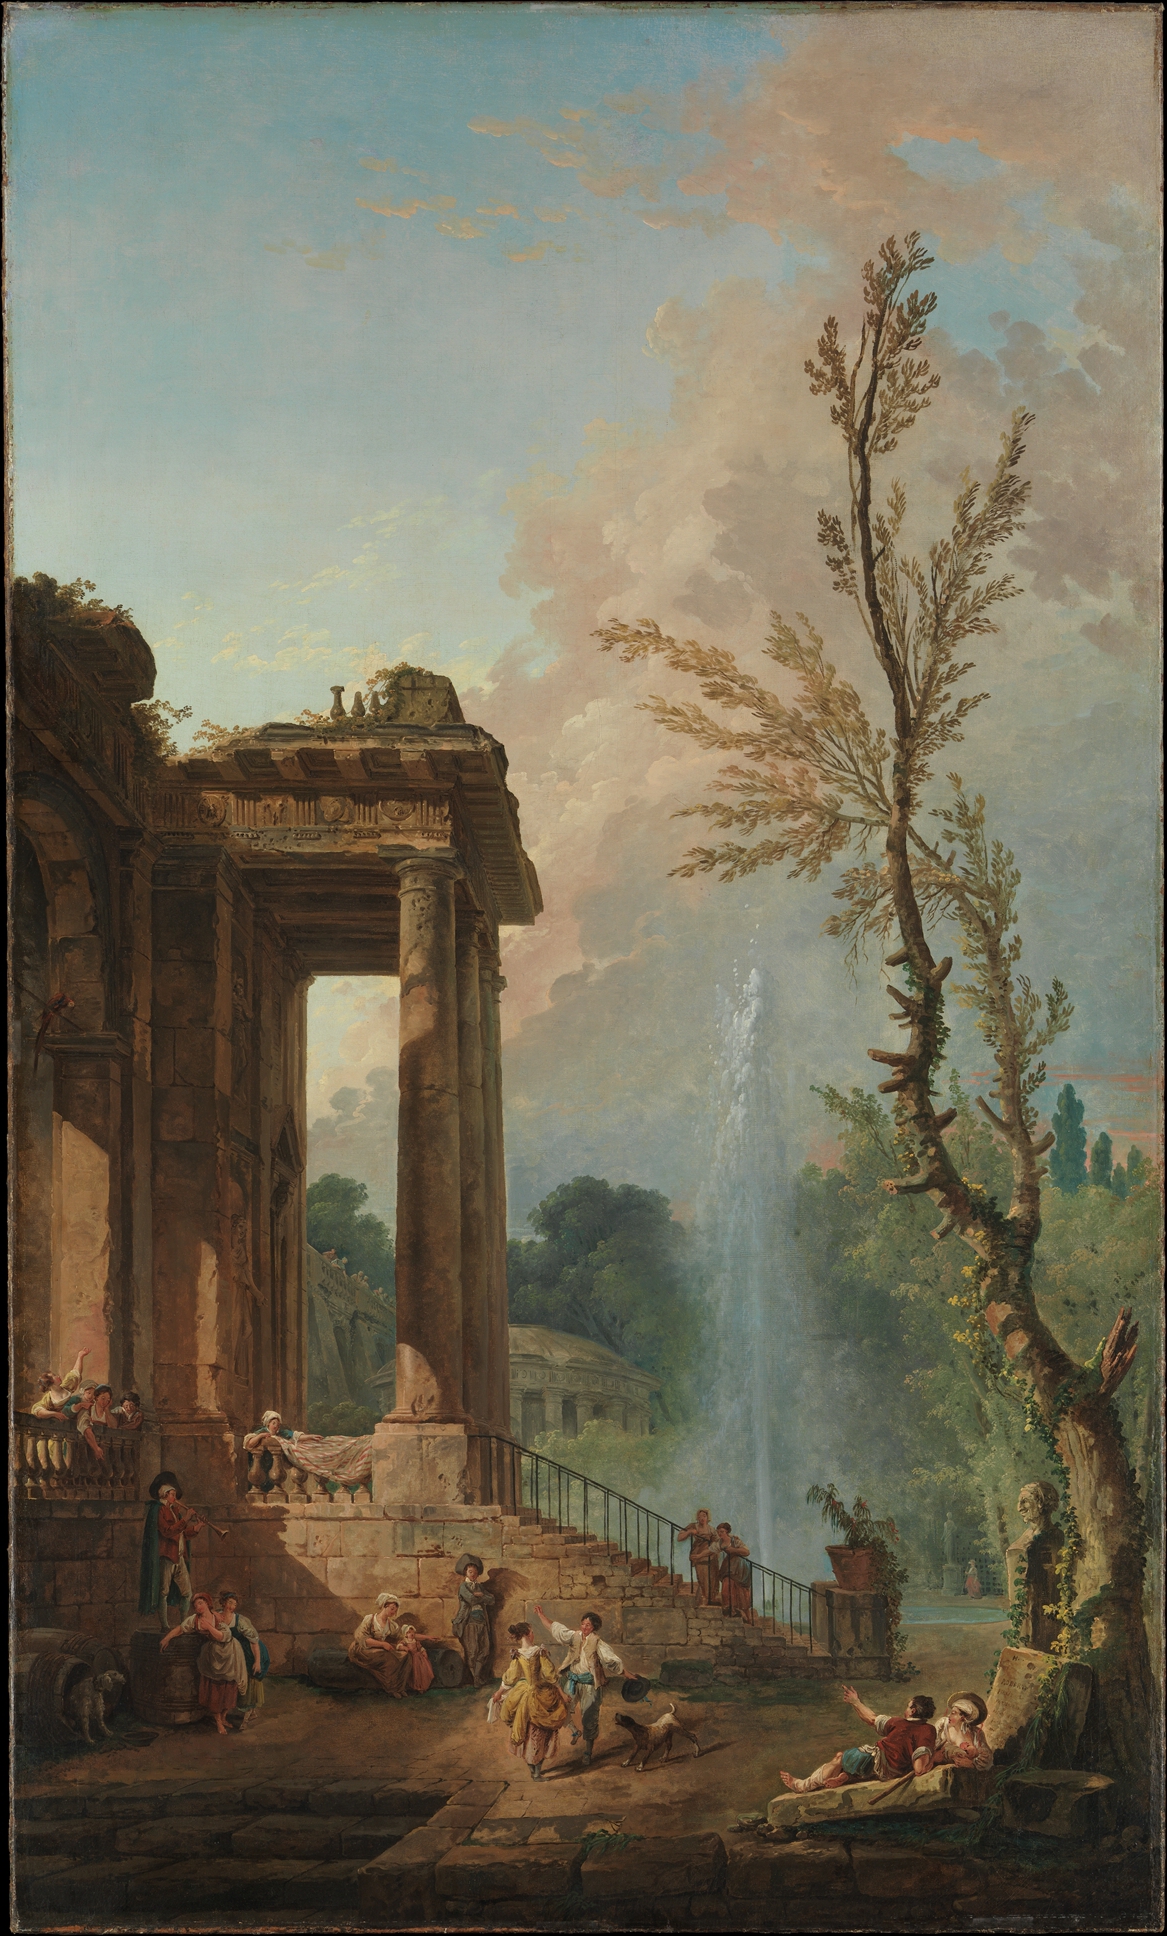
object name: painting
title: The Portico of a Country Mansion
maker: hubert robert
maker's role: artist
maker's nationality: french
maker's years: 1733-1808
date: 1773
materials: canvas, oil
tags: human figures,columns,fountains,ruins